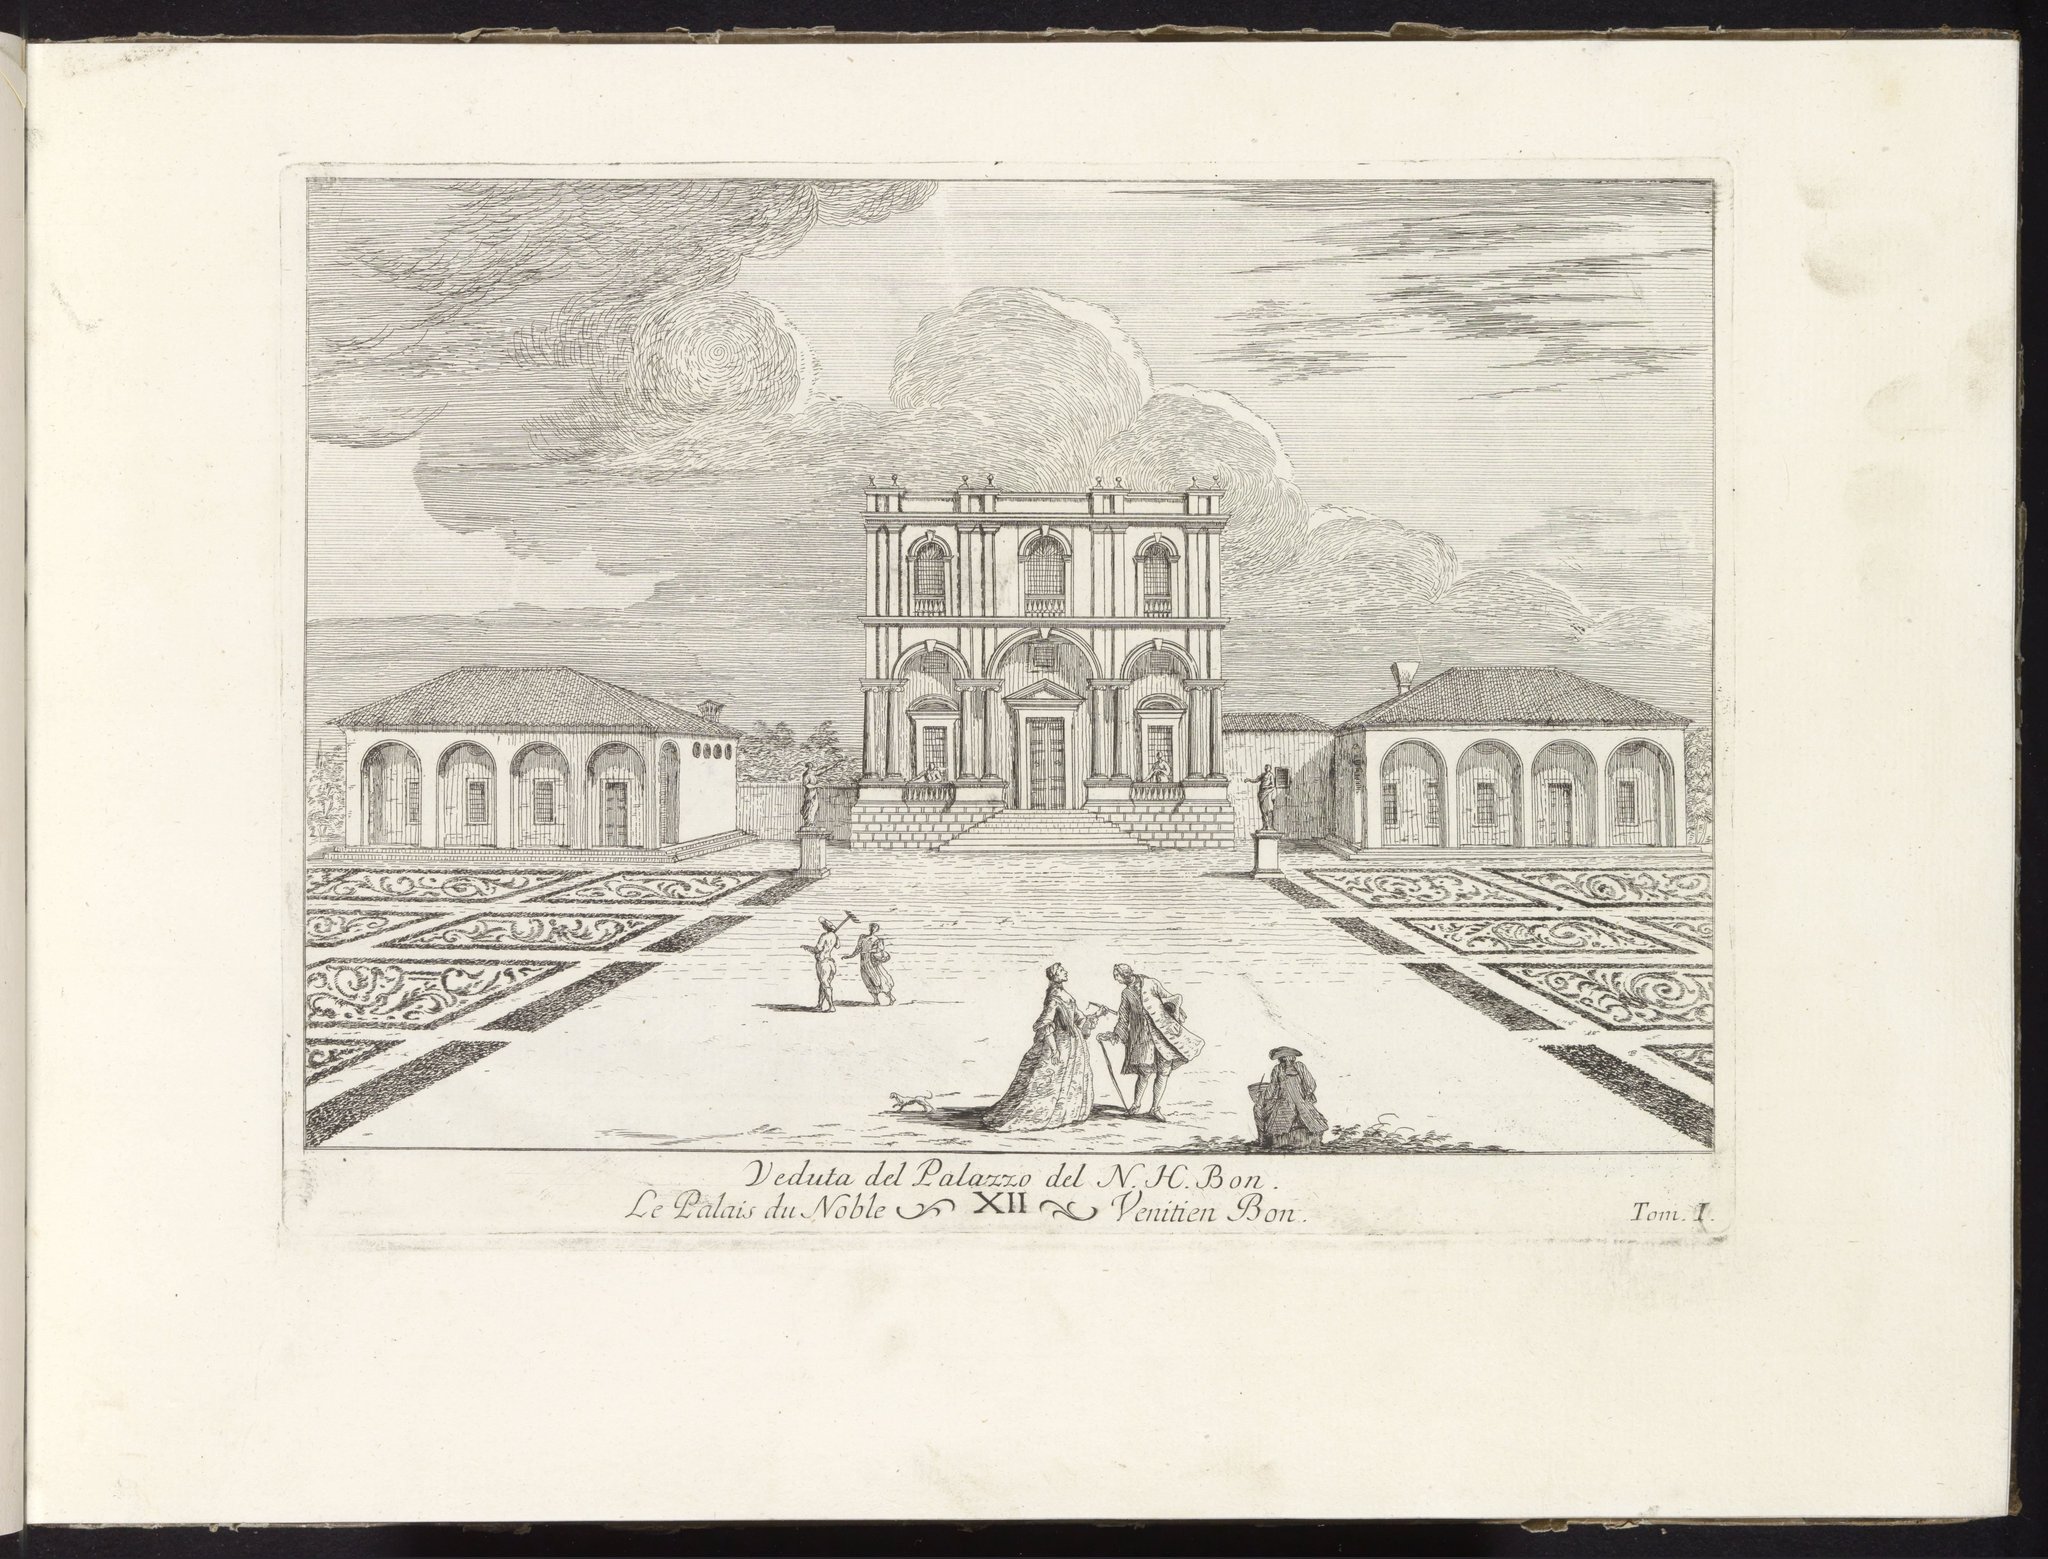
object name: print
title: Les delices de la Brenta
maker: giovanni francesco costa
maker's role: draughtsman, painter, print maker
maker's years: -1773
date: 1750-1760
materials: paper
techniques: etching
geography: venice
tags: garden, hôtel, i.e. small palace in city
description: Gezicht op Palazzo N. H. Bon en omliggende tuinen. Op de voorgrond twee stellen en een tekenaar in de tuin. Genummerd midden onder: XII en rechtsonder: Tom: I. Deze prent maakt deel uit van een album.